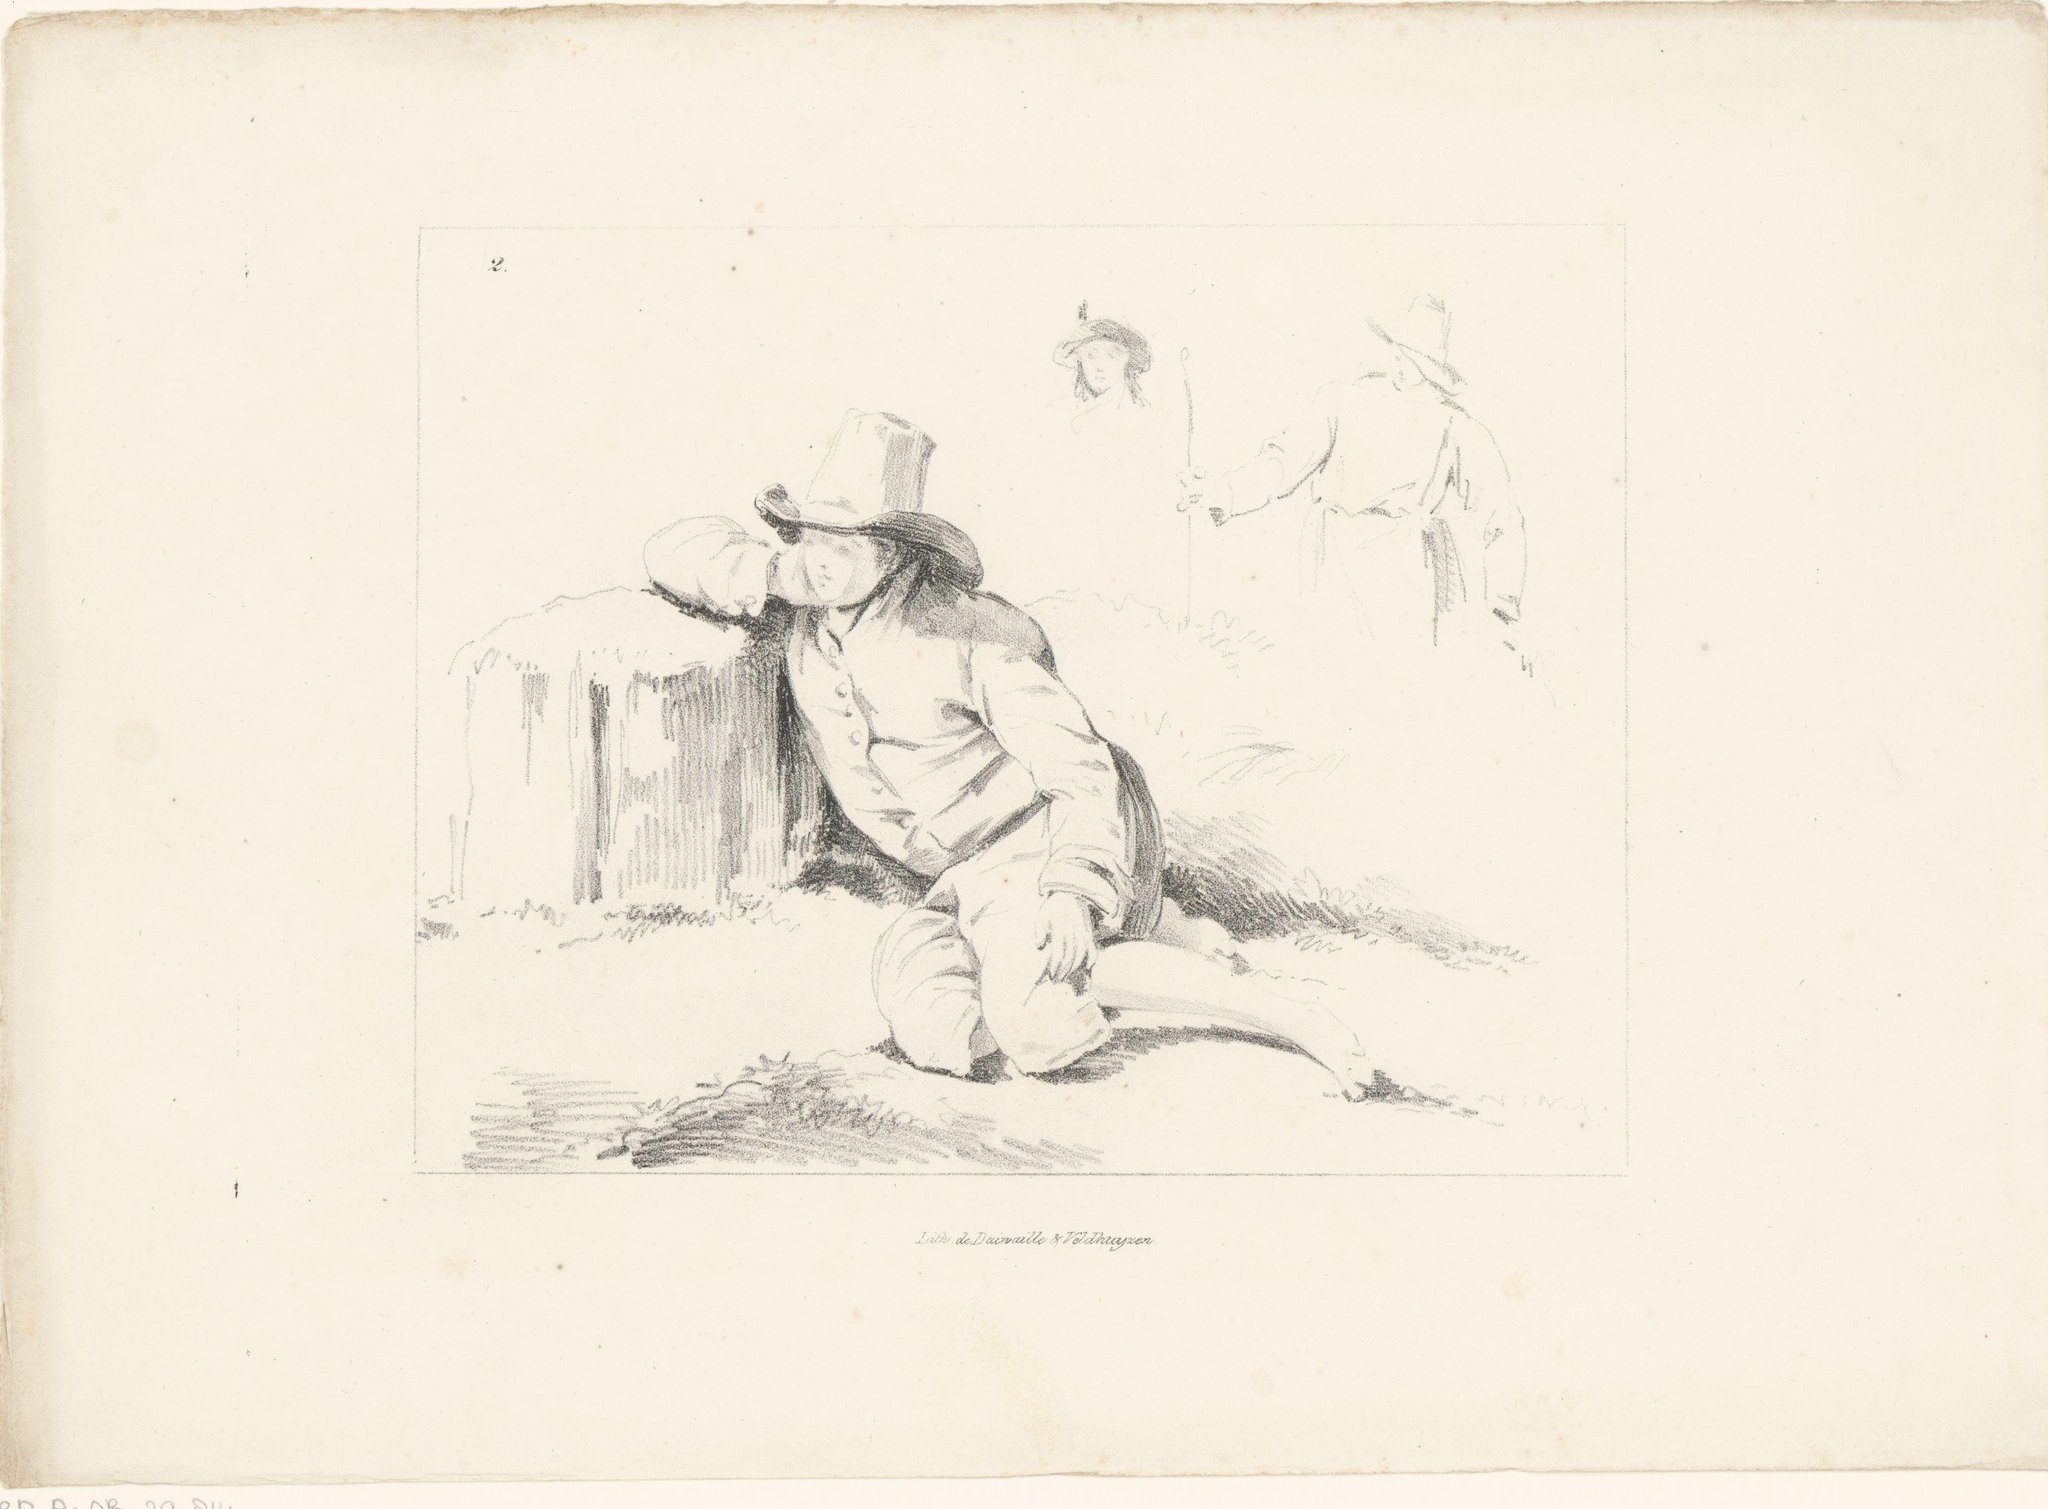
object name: print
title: Op de grond zittende jongeman met hoed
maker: Anonymous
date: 1831-1832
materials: paper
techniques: lithograph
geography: netherlands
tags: youth, adolescent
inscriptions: collector's mark: Lugt 2228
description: Studieblad met een op de grond zittende jongeman met hoed leunend tegen een steen. Rechts een mannenhoofd en herder met staf.